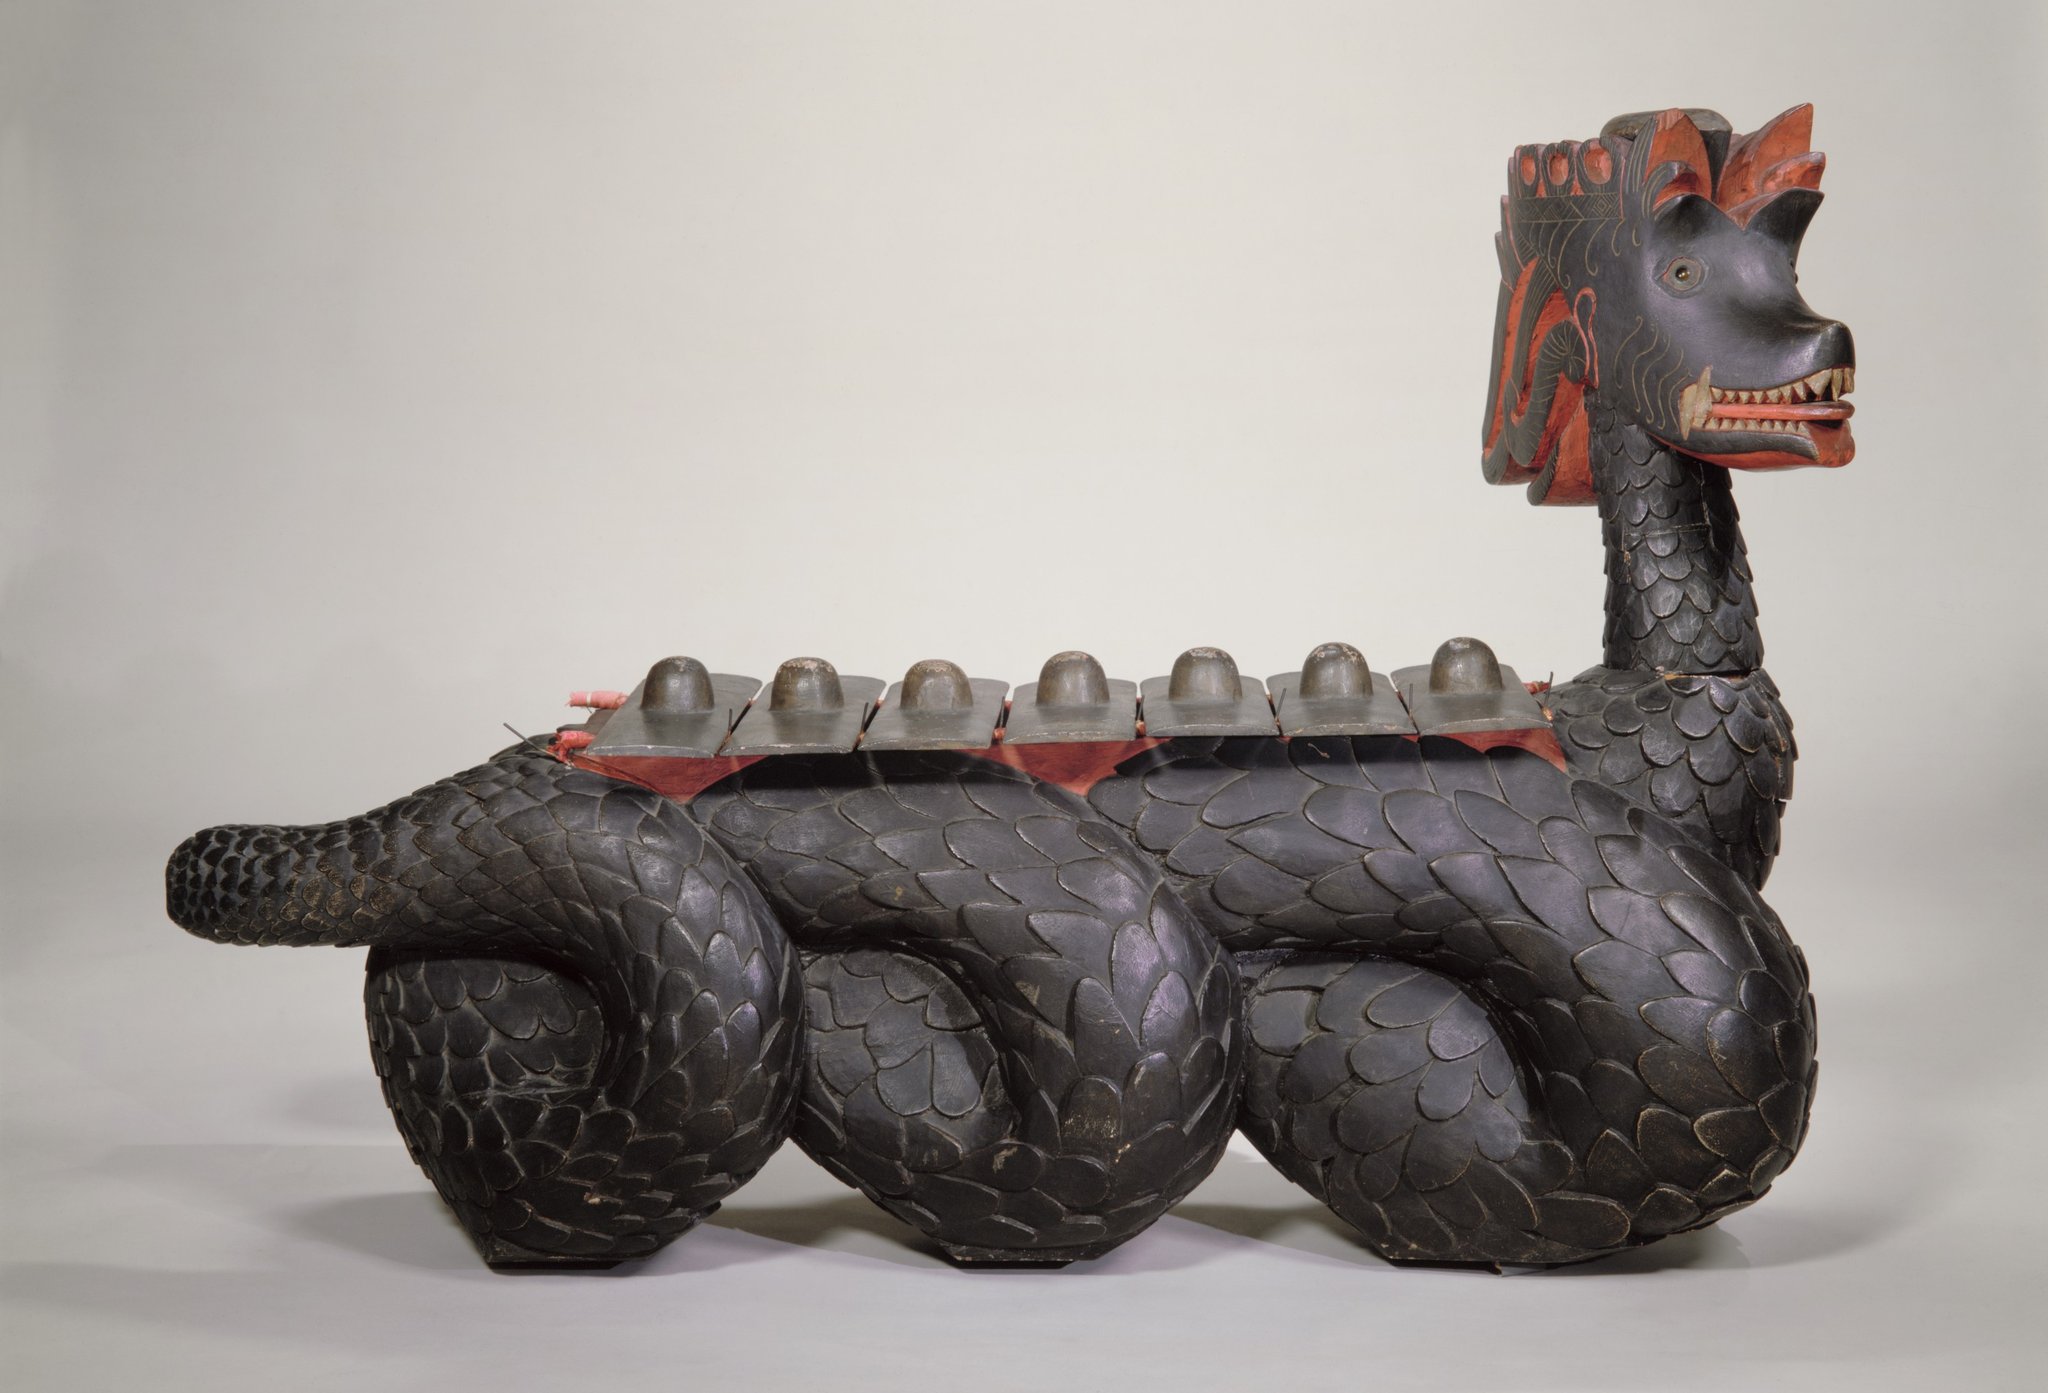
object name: slento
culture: javanese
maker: henry hannah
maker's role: source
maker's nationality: american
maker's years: 1840-1900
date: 1867-1900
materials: metal, wood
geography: indonesia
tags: dragons